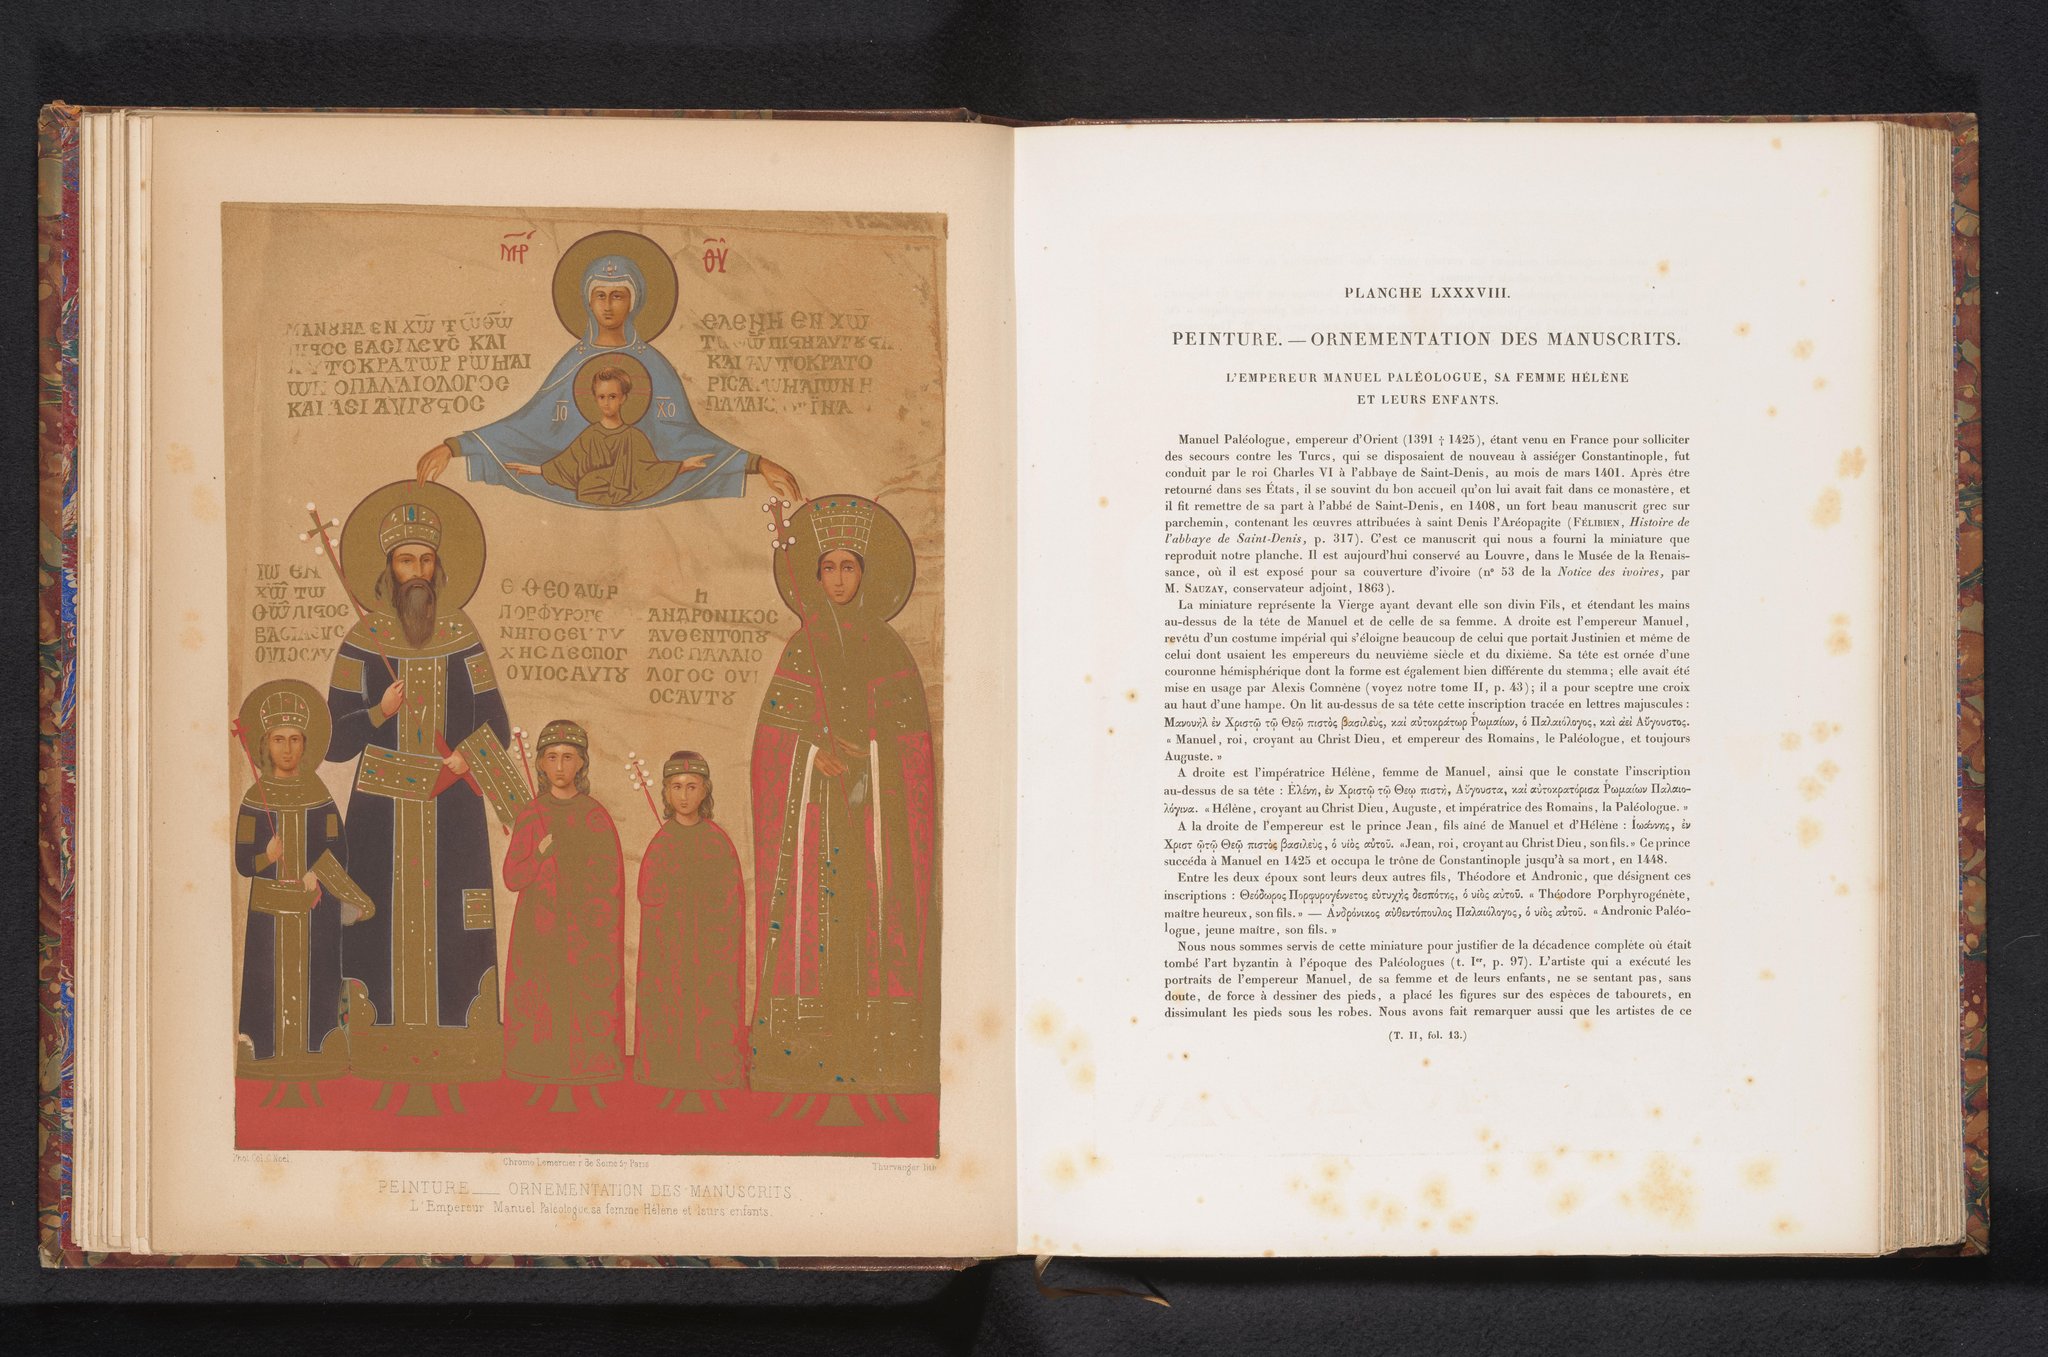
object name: photomechanical print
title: L'Empereur Manuel Paléologue, sa femme Hélène et leurs enfants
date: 1859-1864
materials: paper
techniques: photolithography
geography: paris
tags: parents with their children, emperor, painting (including book-illumination, miniature-painting)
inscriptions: name: ‘Phot. Col. C. Noel/ Thurvanger lith’